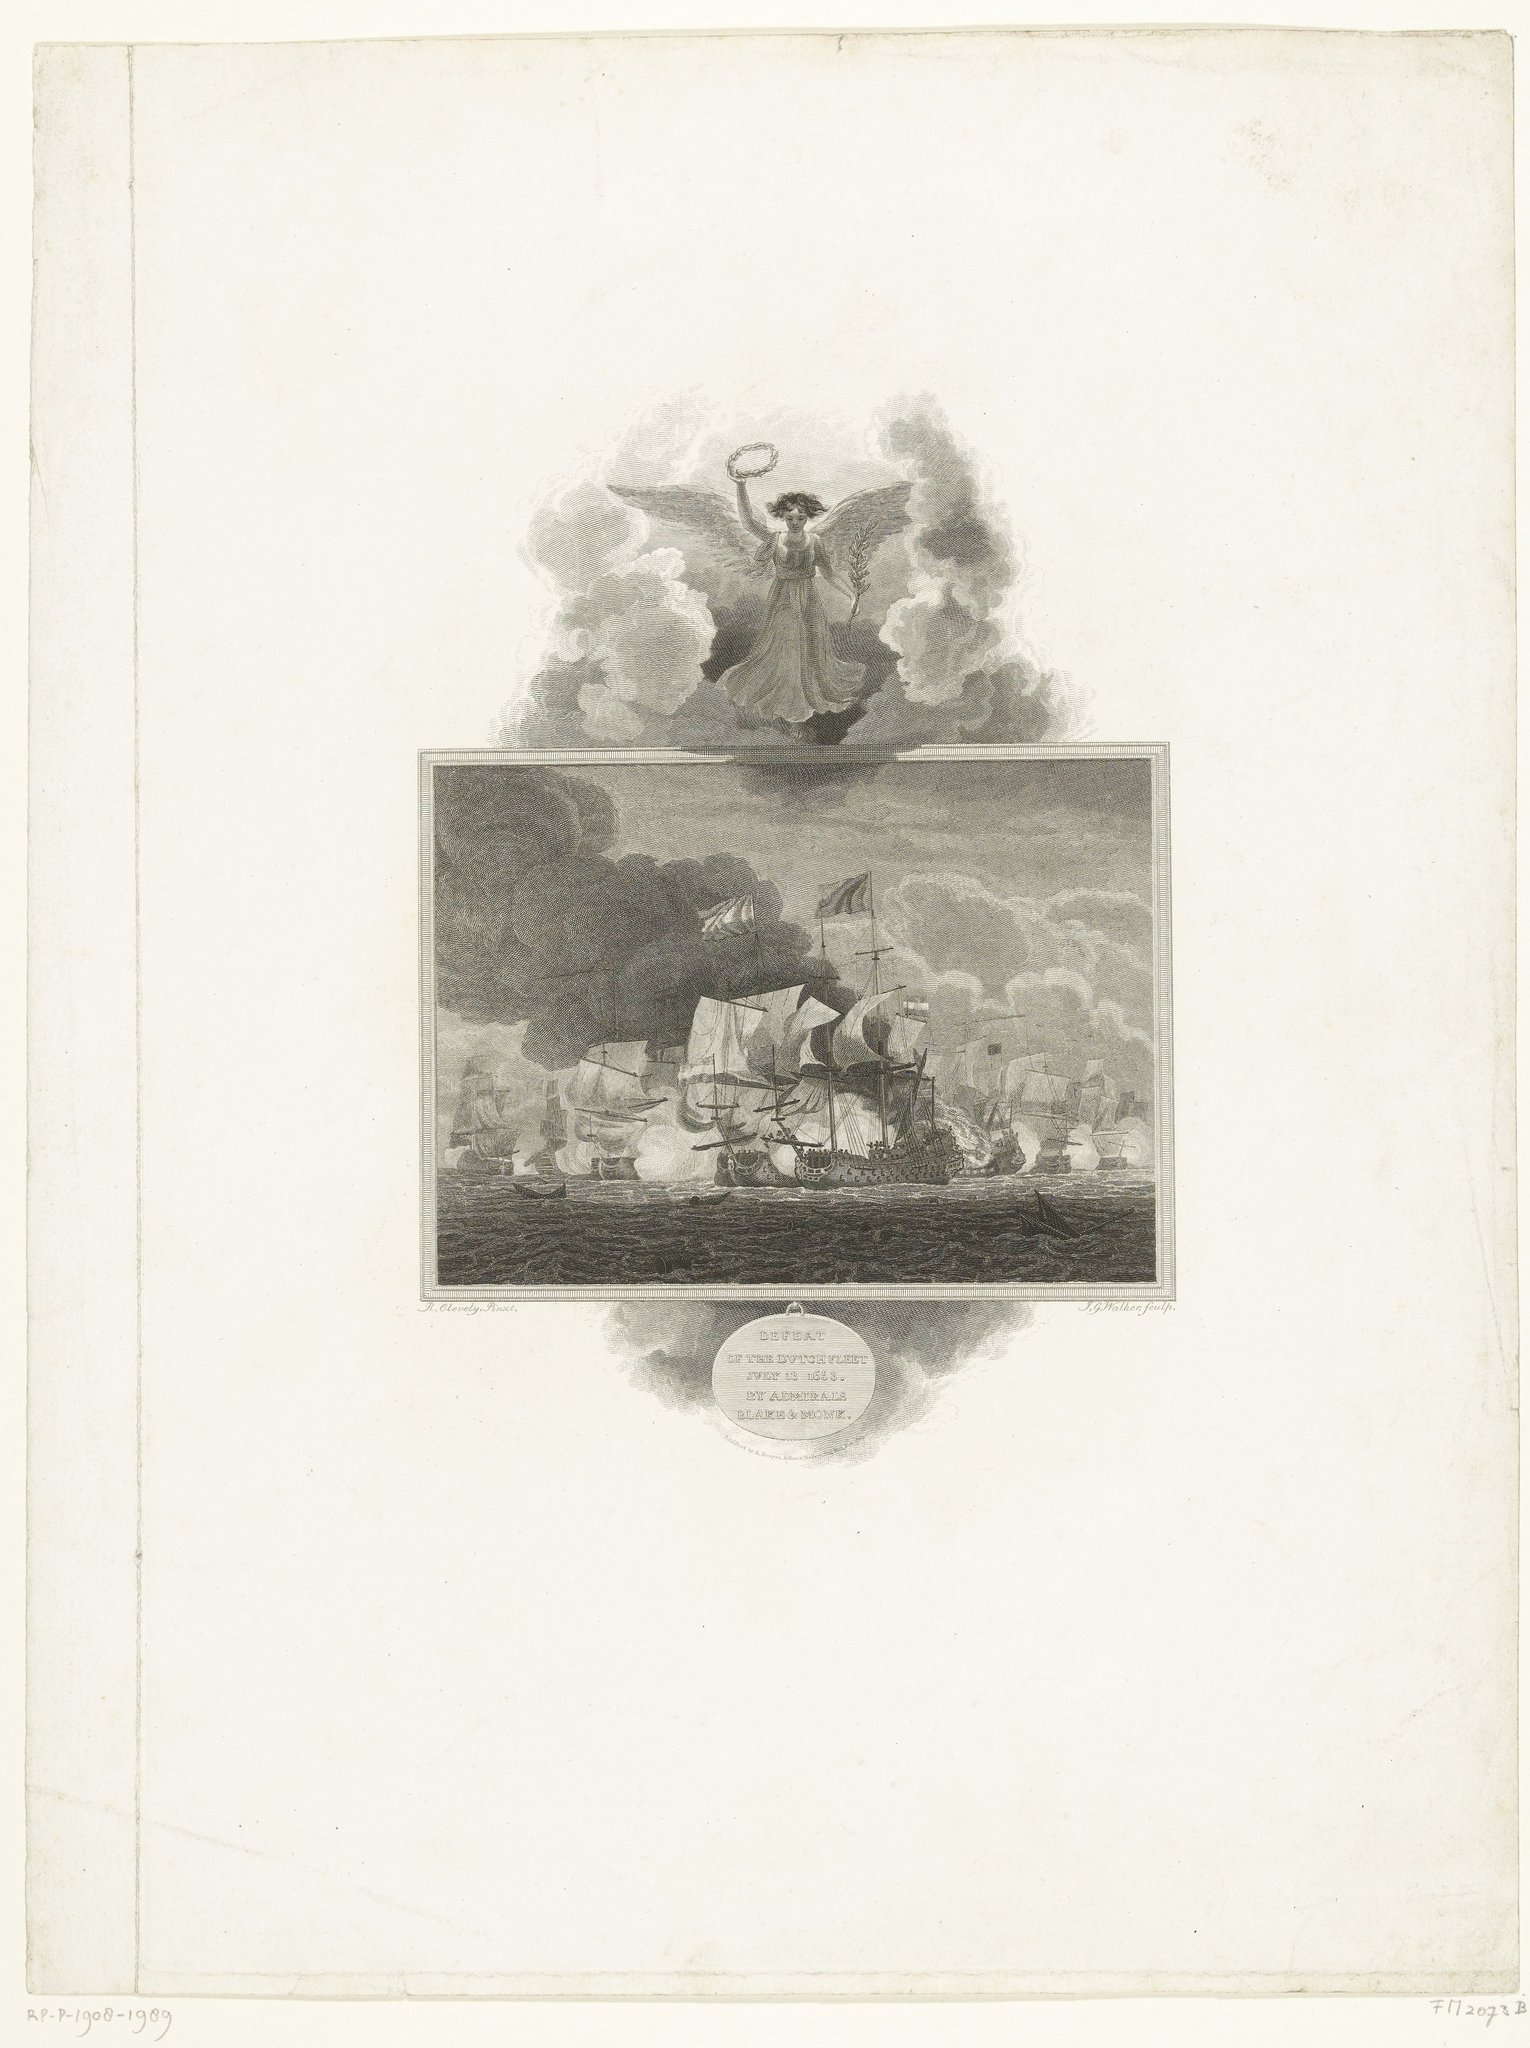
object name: history print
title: Defeat of the Dutch fleet July 13 1653. By admirals Blake & Monk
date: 1803-1811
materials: paper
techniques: engraving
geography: england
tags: brielle, maarten harpertszoon tromp, battle (+ naval force), battle of the gabbard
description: Nederlaaag van de Staatse vloot onder M. Tromp tijdends de zeeslag bij Nieuwpoort tegen de Engelse vloot onder Blake en Monck, 12-13 juni 1653. Omlijste voorstelling met bovenaan een engel met een lauwerkrans en olijftak, onderaan een penning met de Engelse titel.